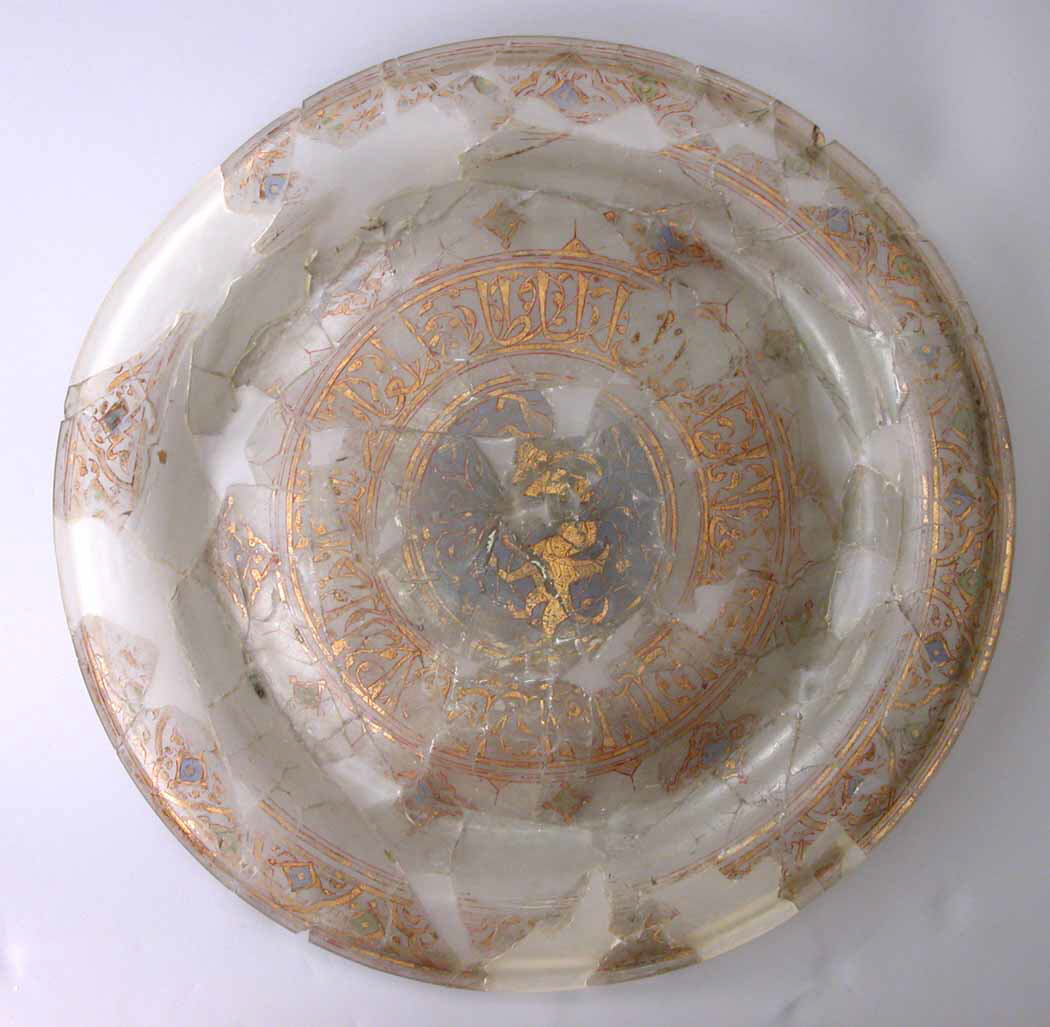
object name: dish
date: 1201-1300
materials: glass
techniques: enamel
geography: iran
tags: sphinx